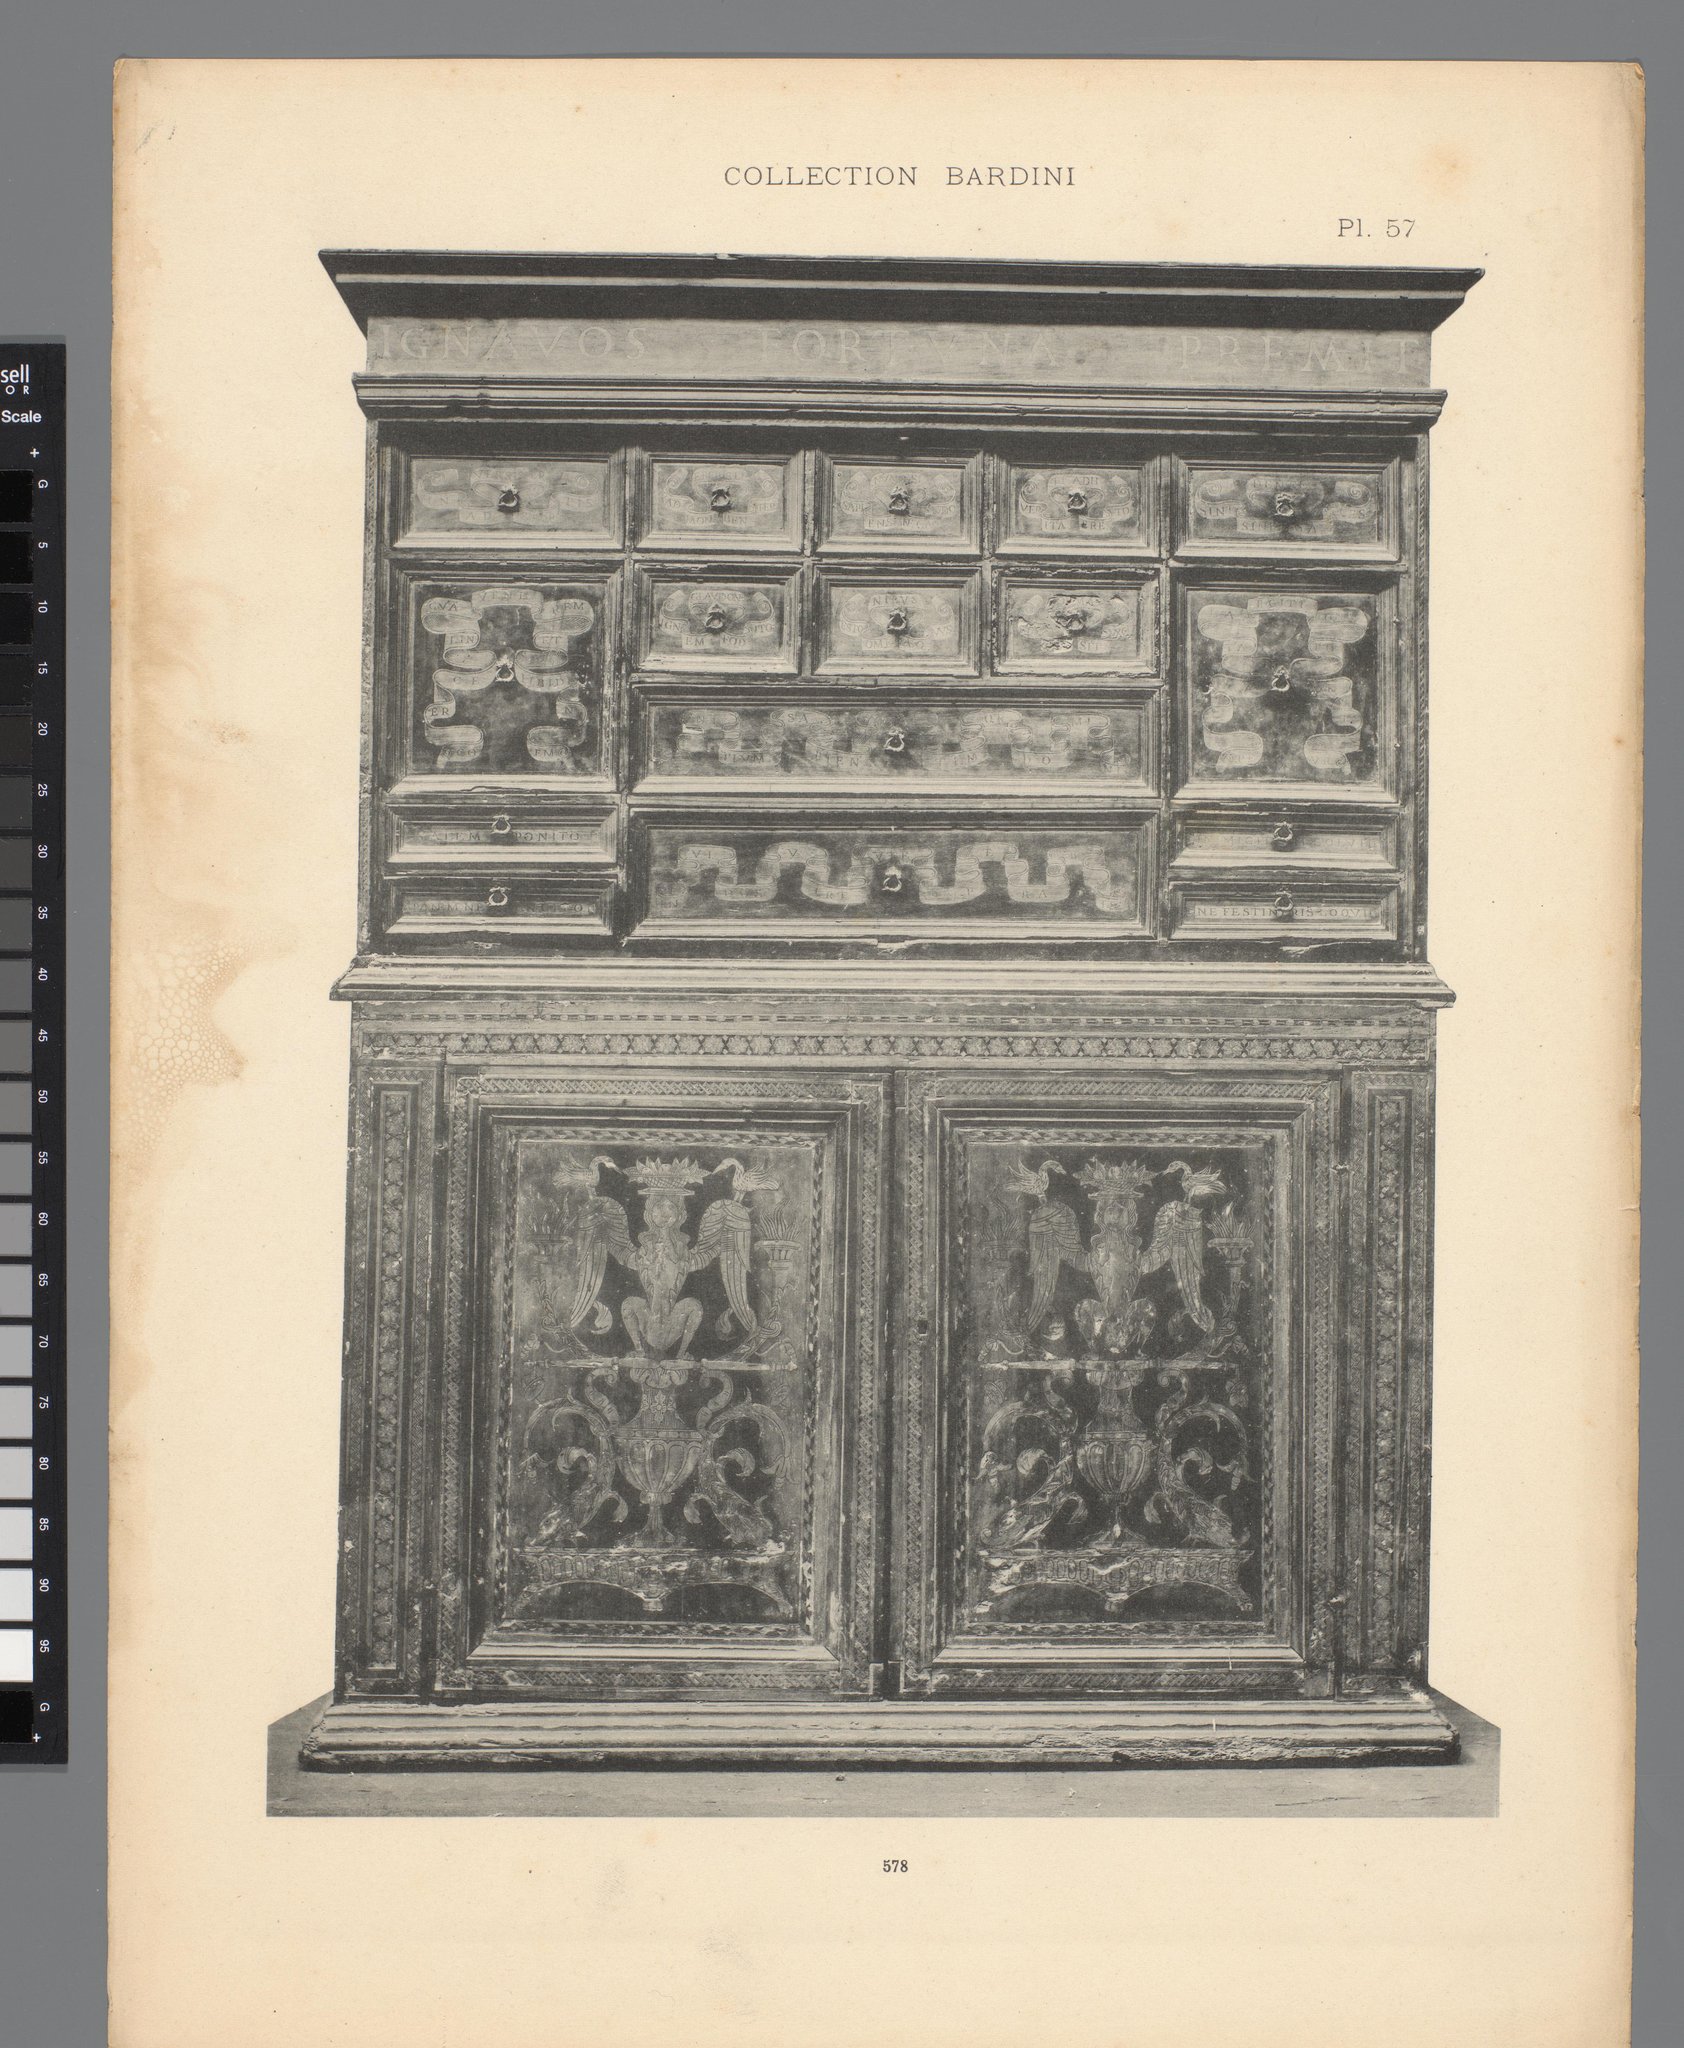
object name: photomechanical print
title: Collection Bardini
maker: Anonymous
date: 1875-1930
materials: paper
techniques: photograph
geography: florence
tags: ornamental cupboard (+ wood and other phytogenic material)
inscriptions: number: ‘Pl. 57’